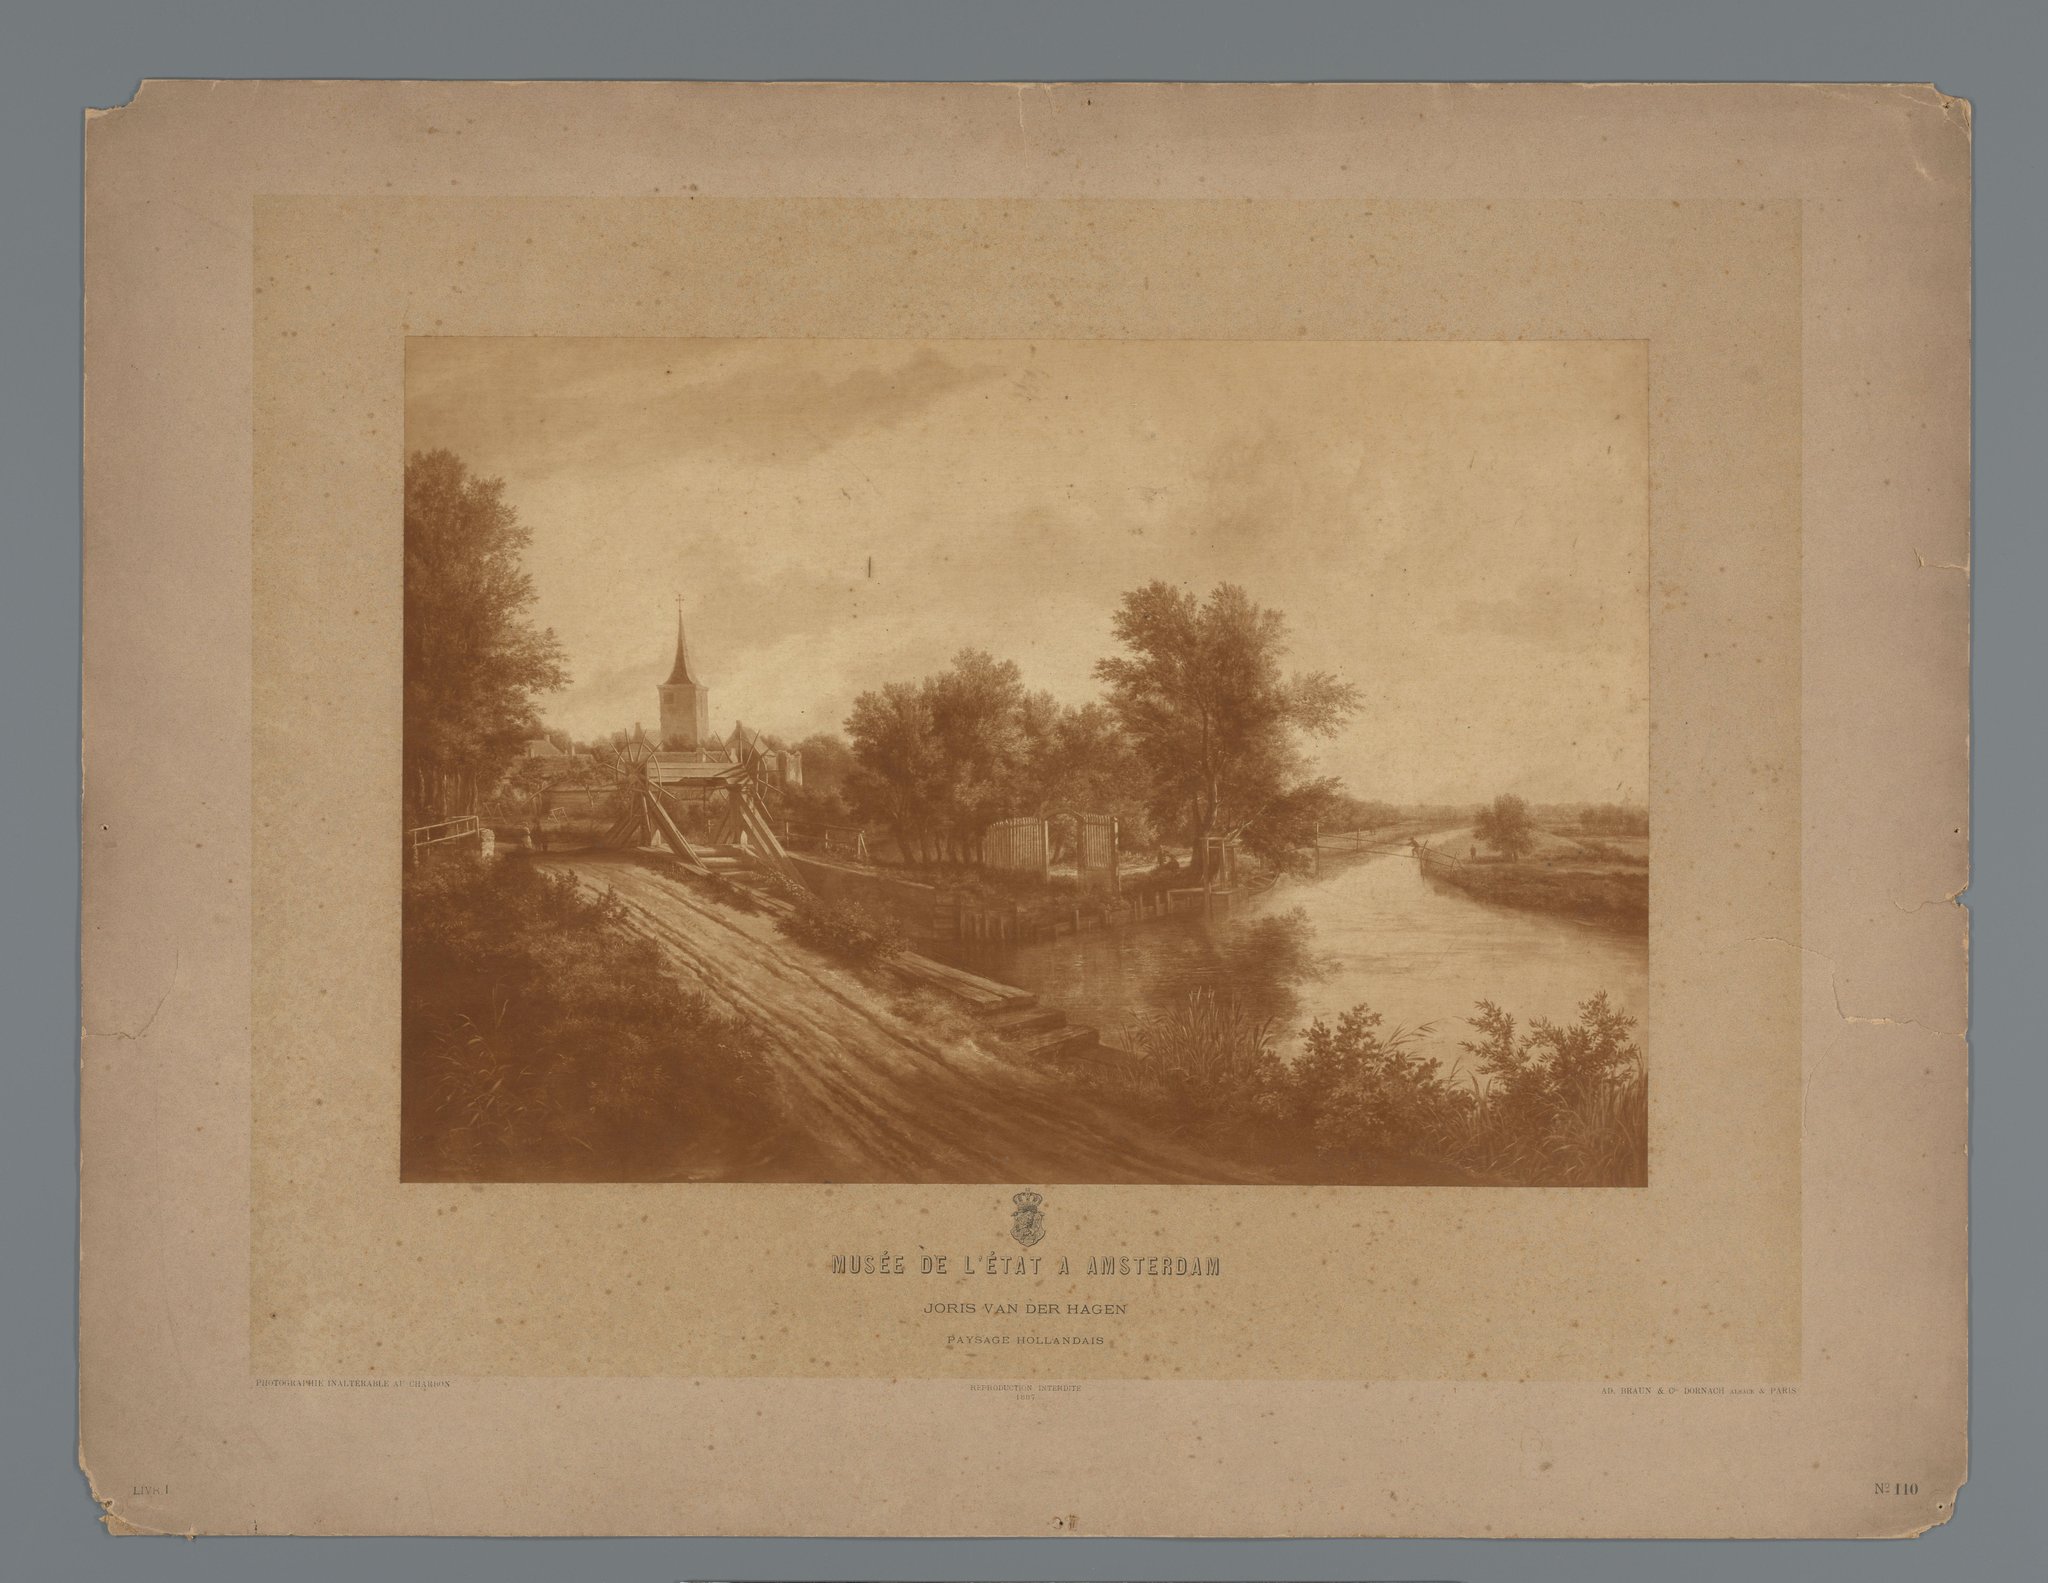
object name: reproduction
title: Fotoreproductie van een schilderij van een Hollands landschap door Joris van der Haagen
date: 1887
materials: cardboard, paper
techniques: carbon print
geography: amsterdam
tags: prospect of village, silhouette of village, river, netherlands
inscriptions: number: ‘Livr. I/ No 110’